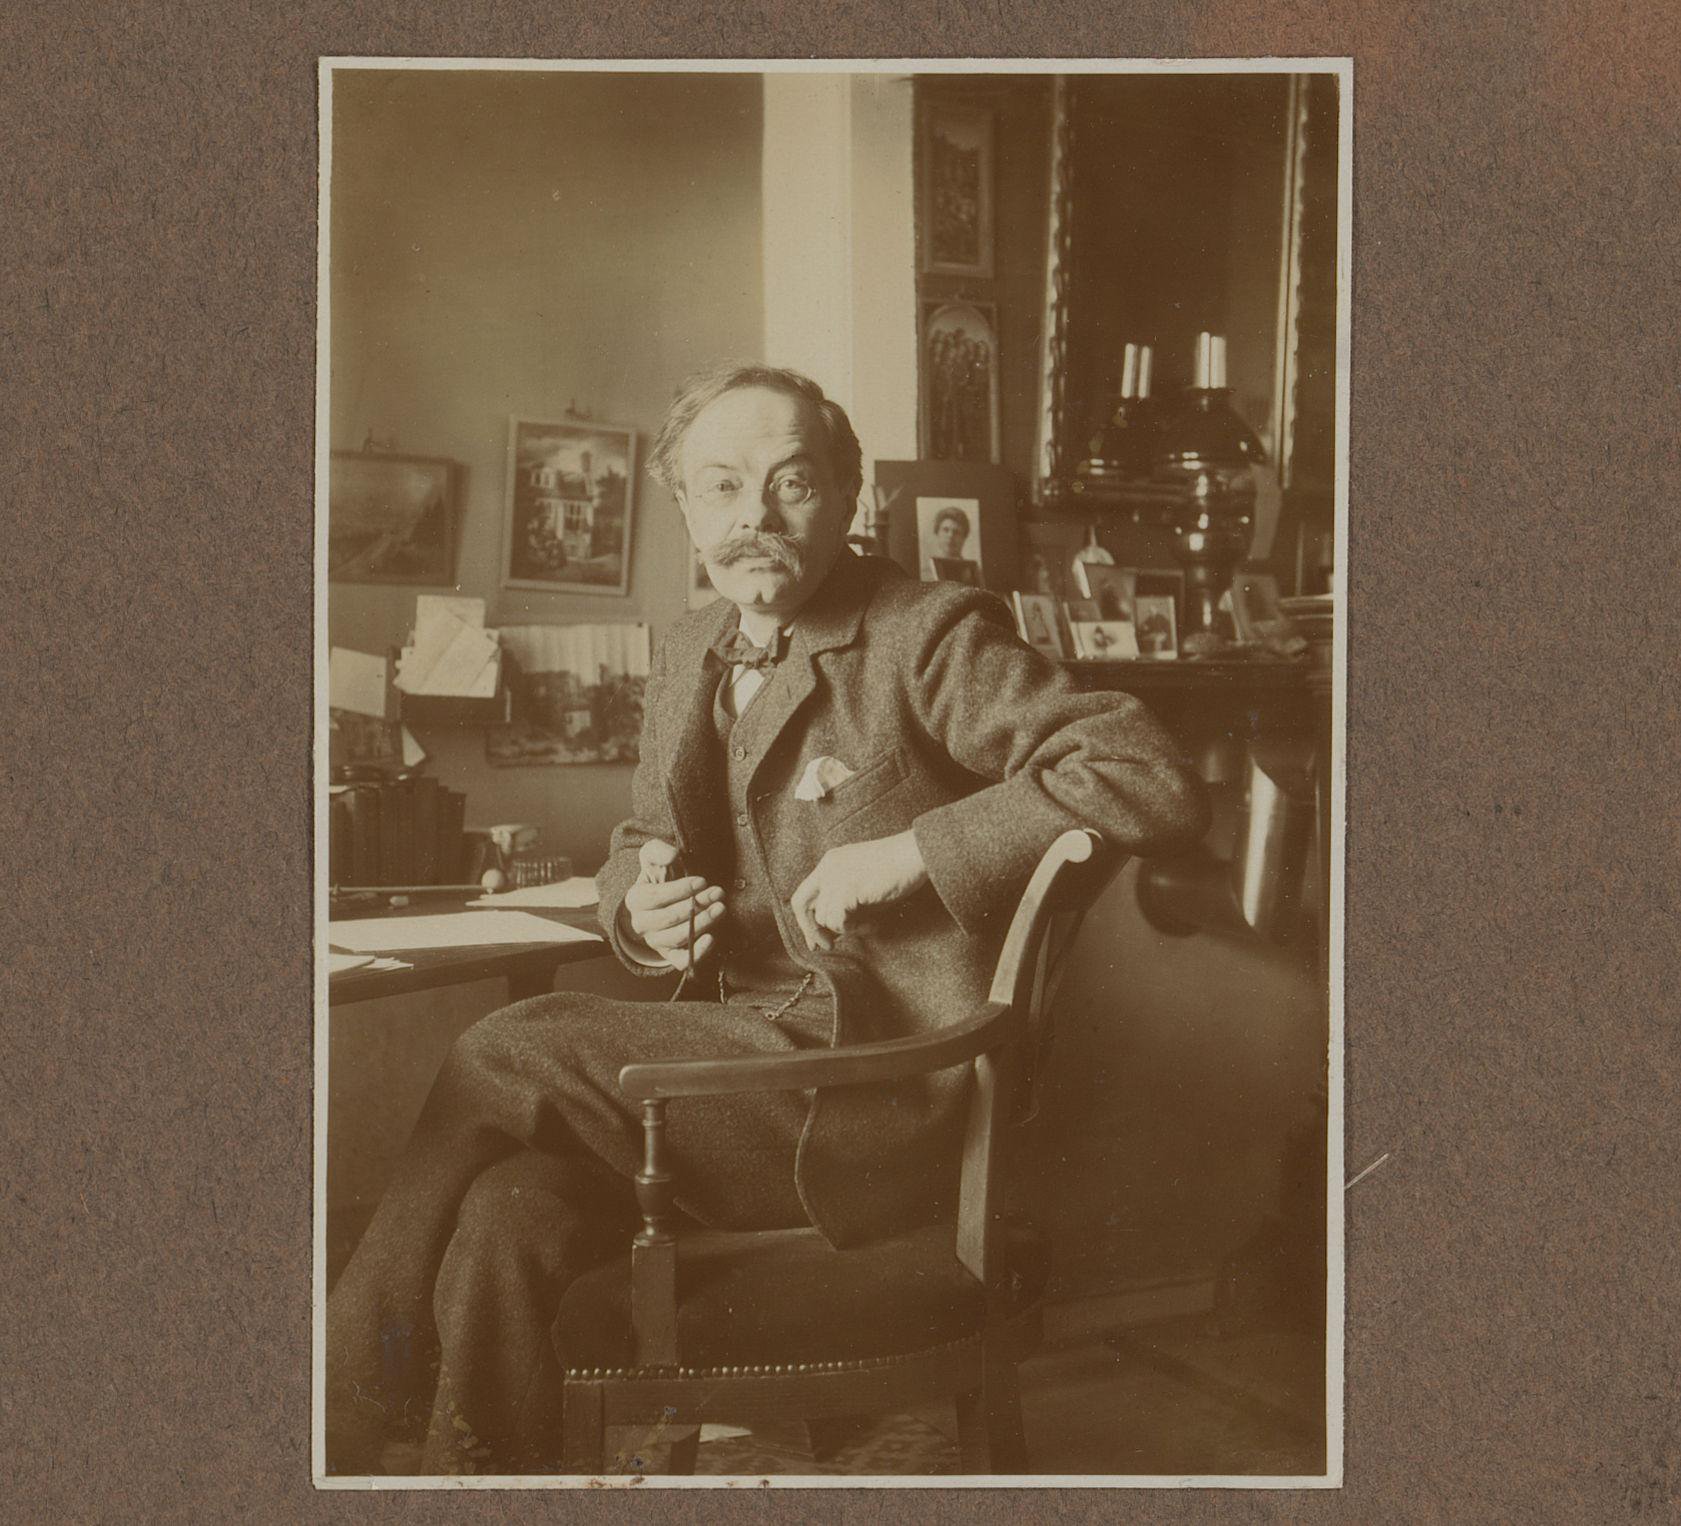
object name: photograph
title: Alphons Diepenbrock zittend aan een bureau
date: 1908-1915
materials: photographic support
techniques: photography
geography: netherlands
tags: amsterdam, alphons diepenbrock, netherlands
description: Foto op bruin albumblad 47 van familiealbum van Alphons Diepenbrock.